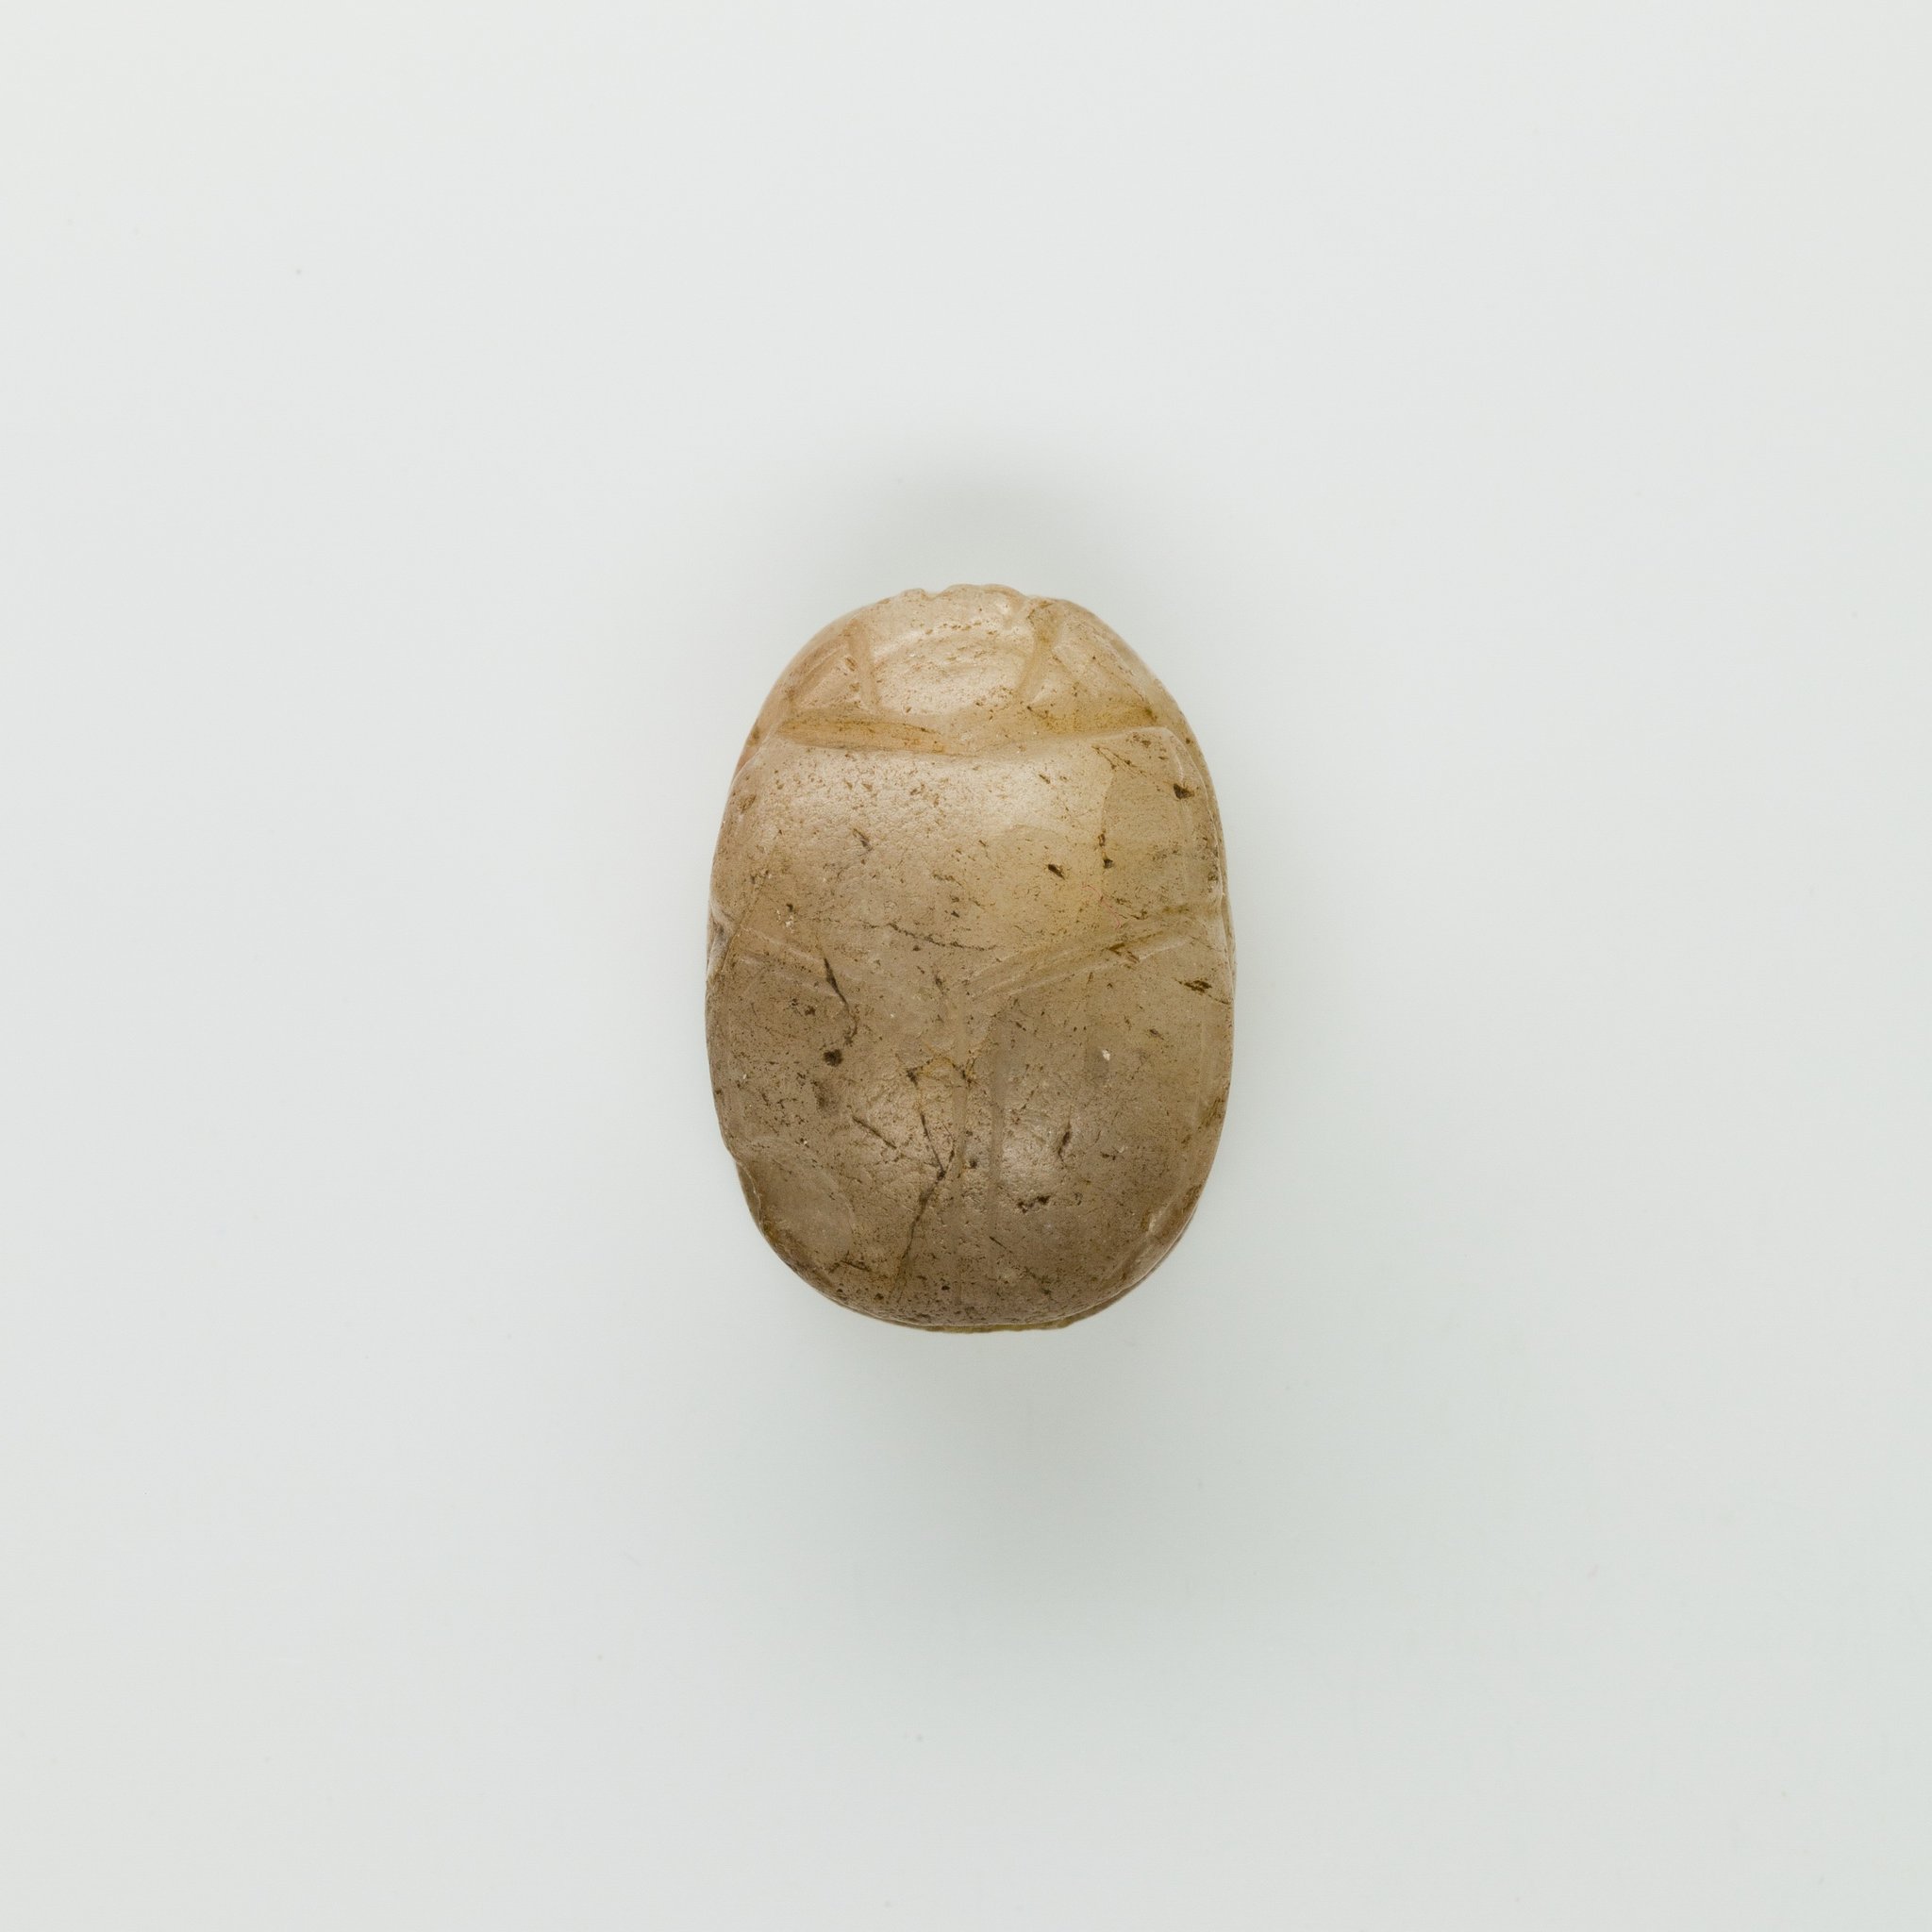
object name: scarab, ramesses ii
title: Scarab of Ramesses II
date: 1295-1070 BCE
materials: quartz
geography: egypt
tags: scarabs